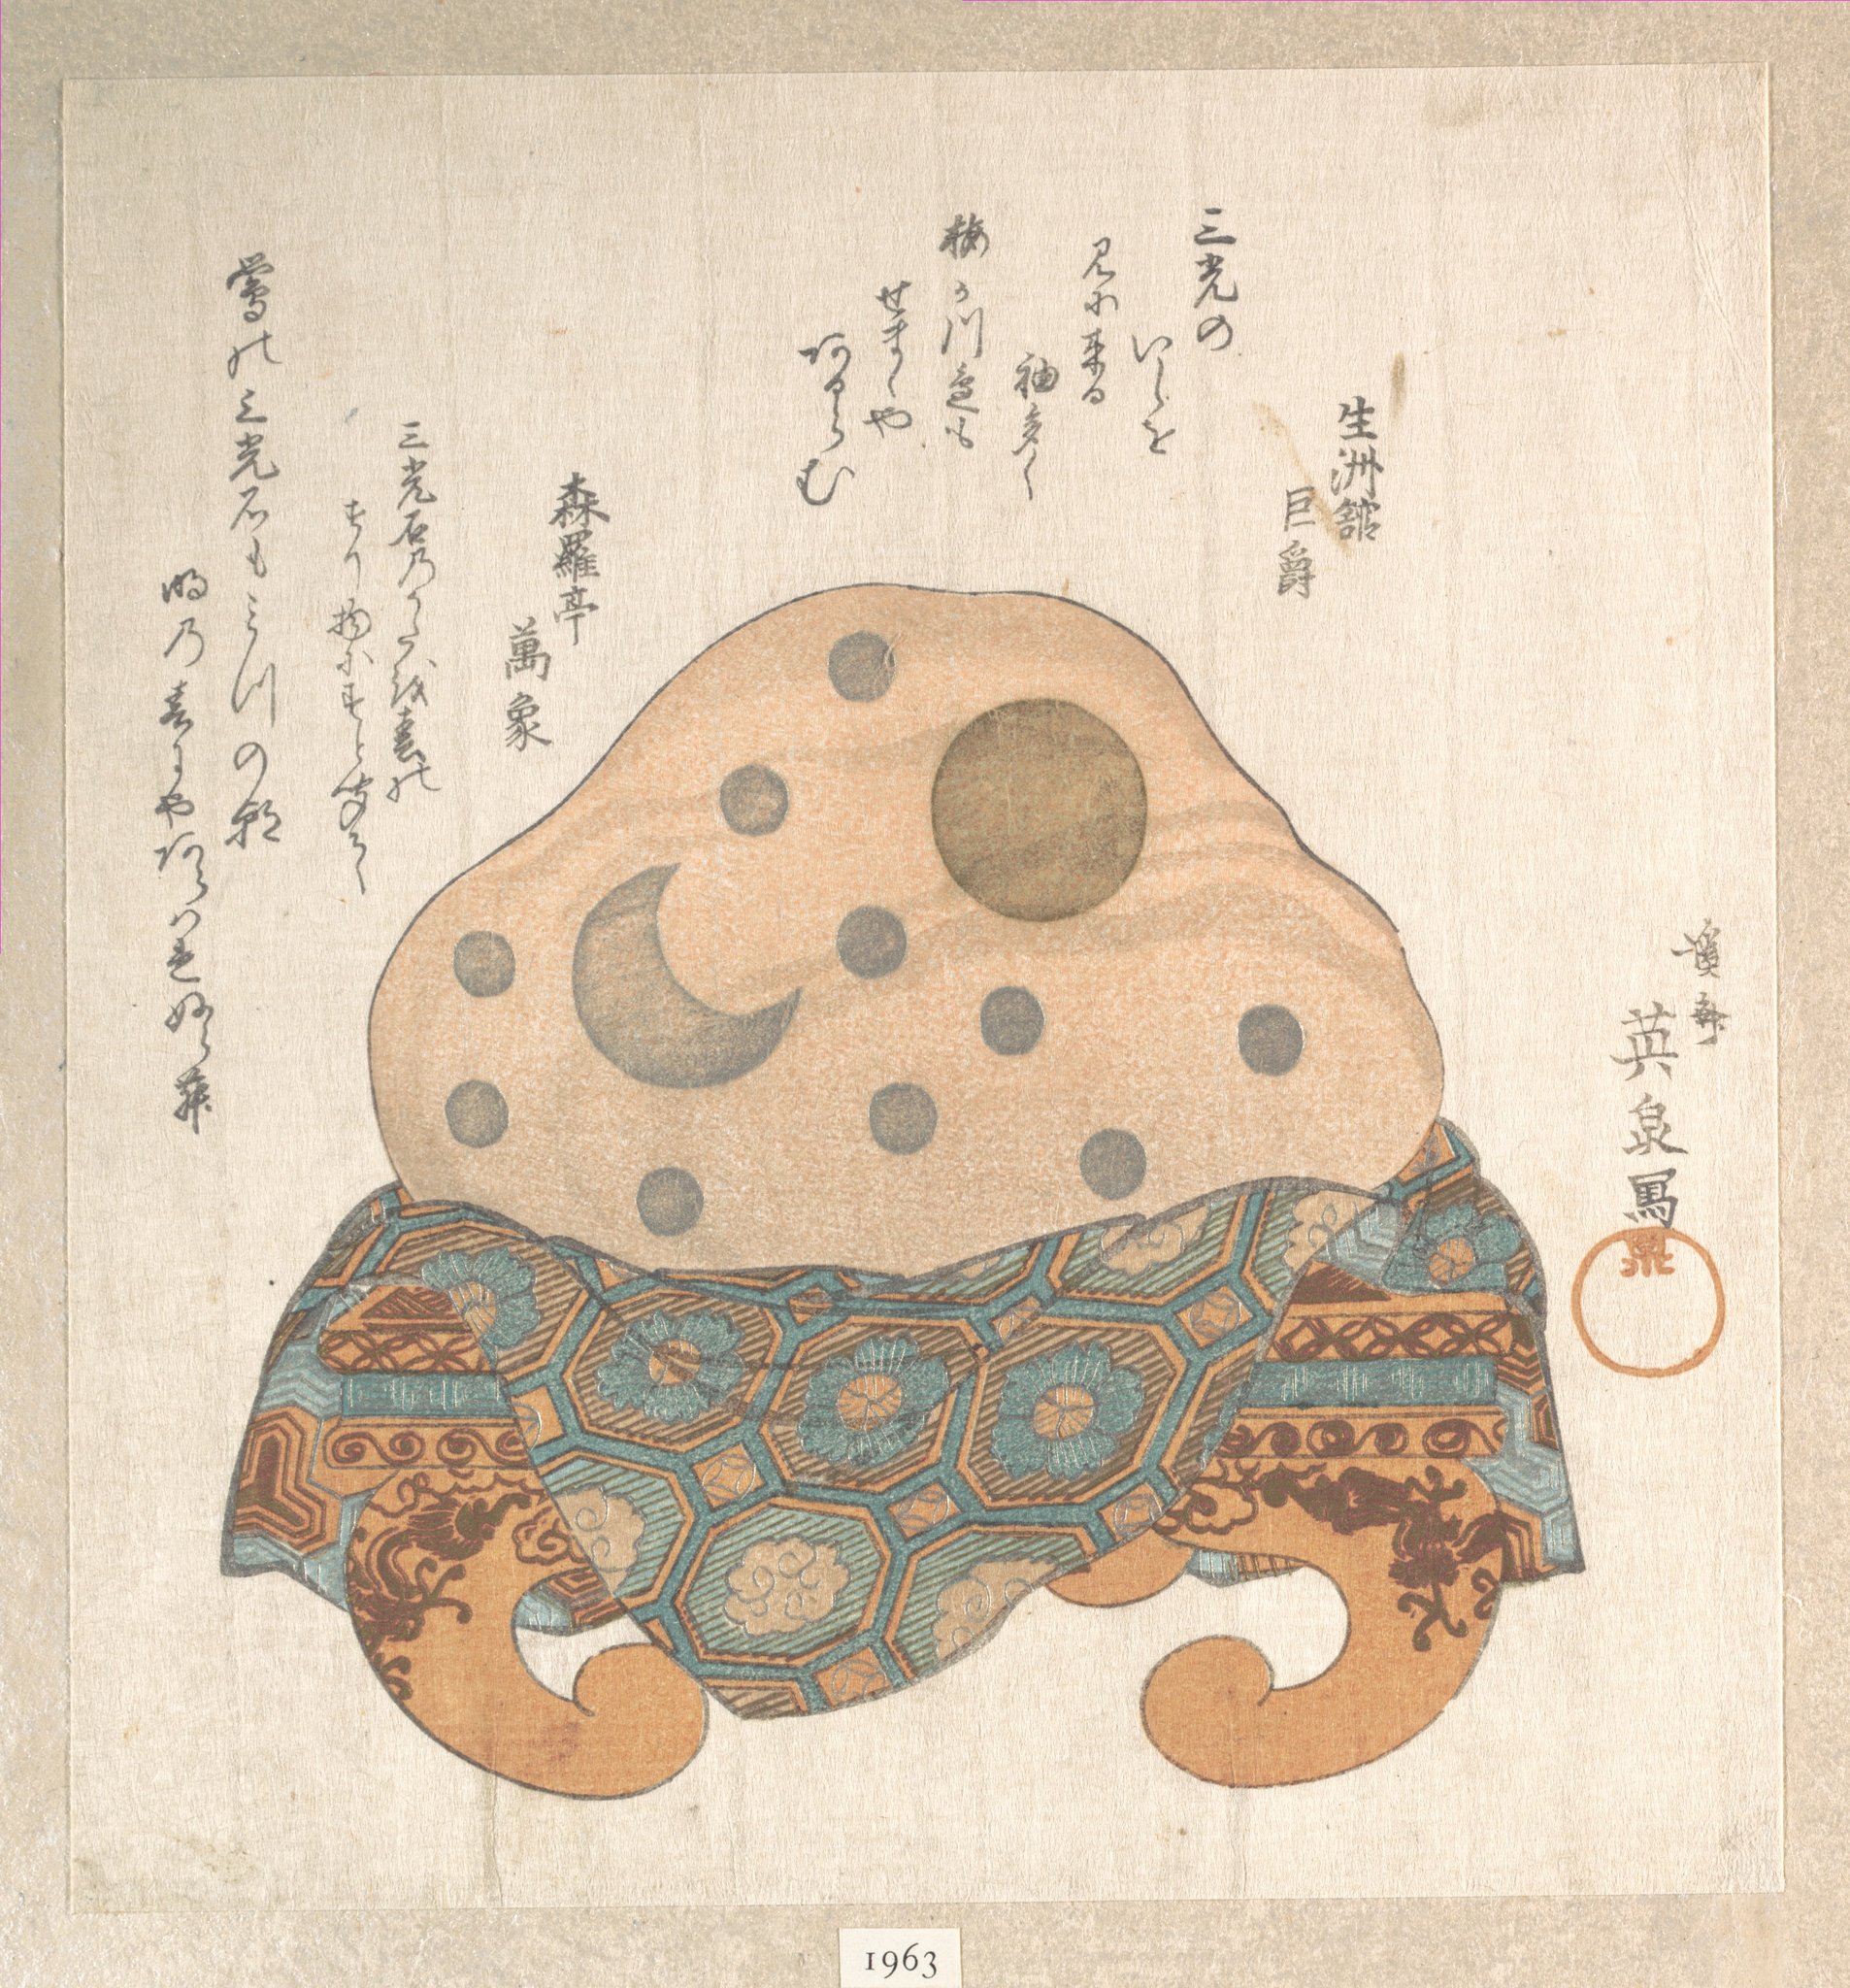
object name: print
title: Stone of Three Lights: Sun, Moon and Star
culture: japanese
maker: keisai eisen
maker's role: artist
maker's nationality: japanese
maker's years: 1790-1848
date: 1801-1900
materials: ink, paper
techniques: surimono, woodblock print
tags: moon,stars,sun